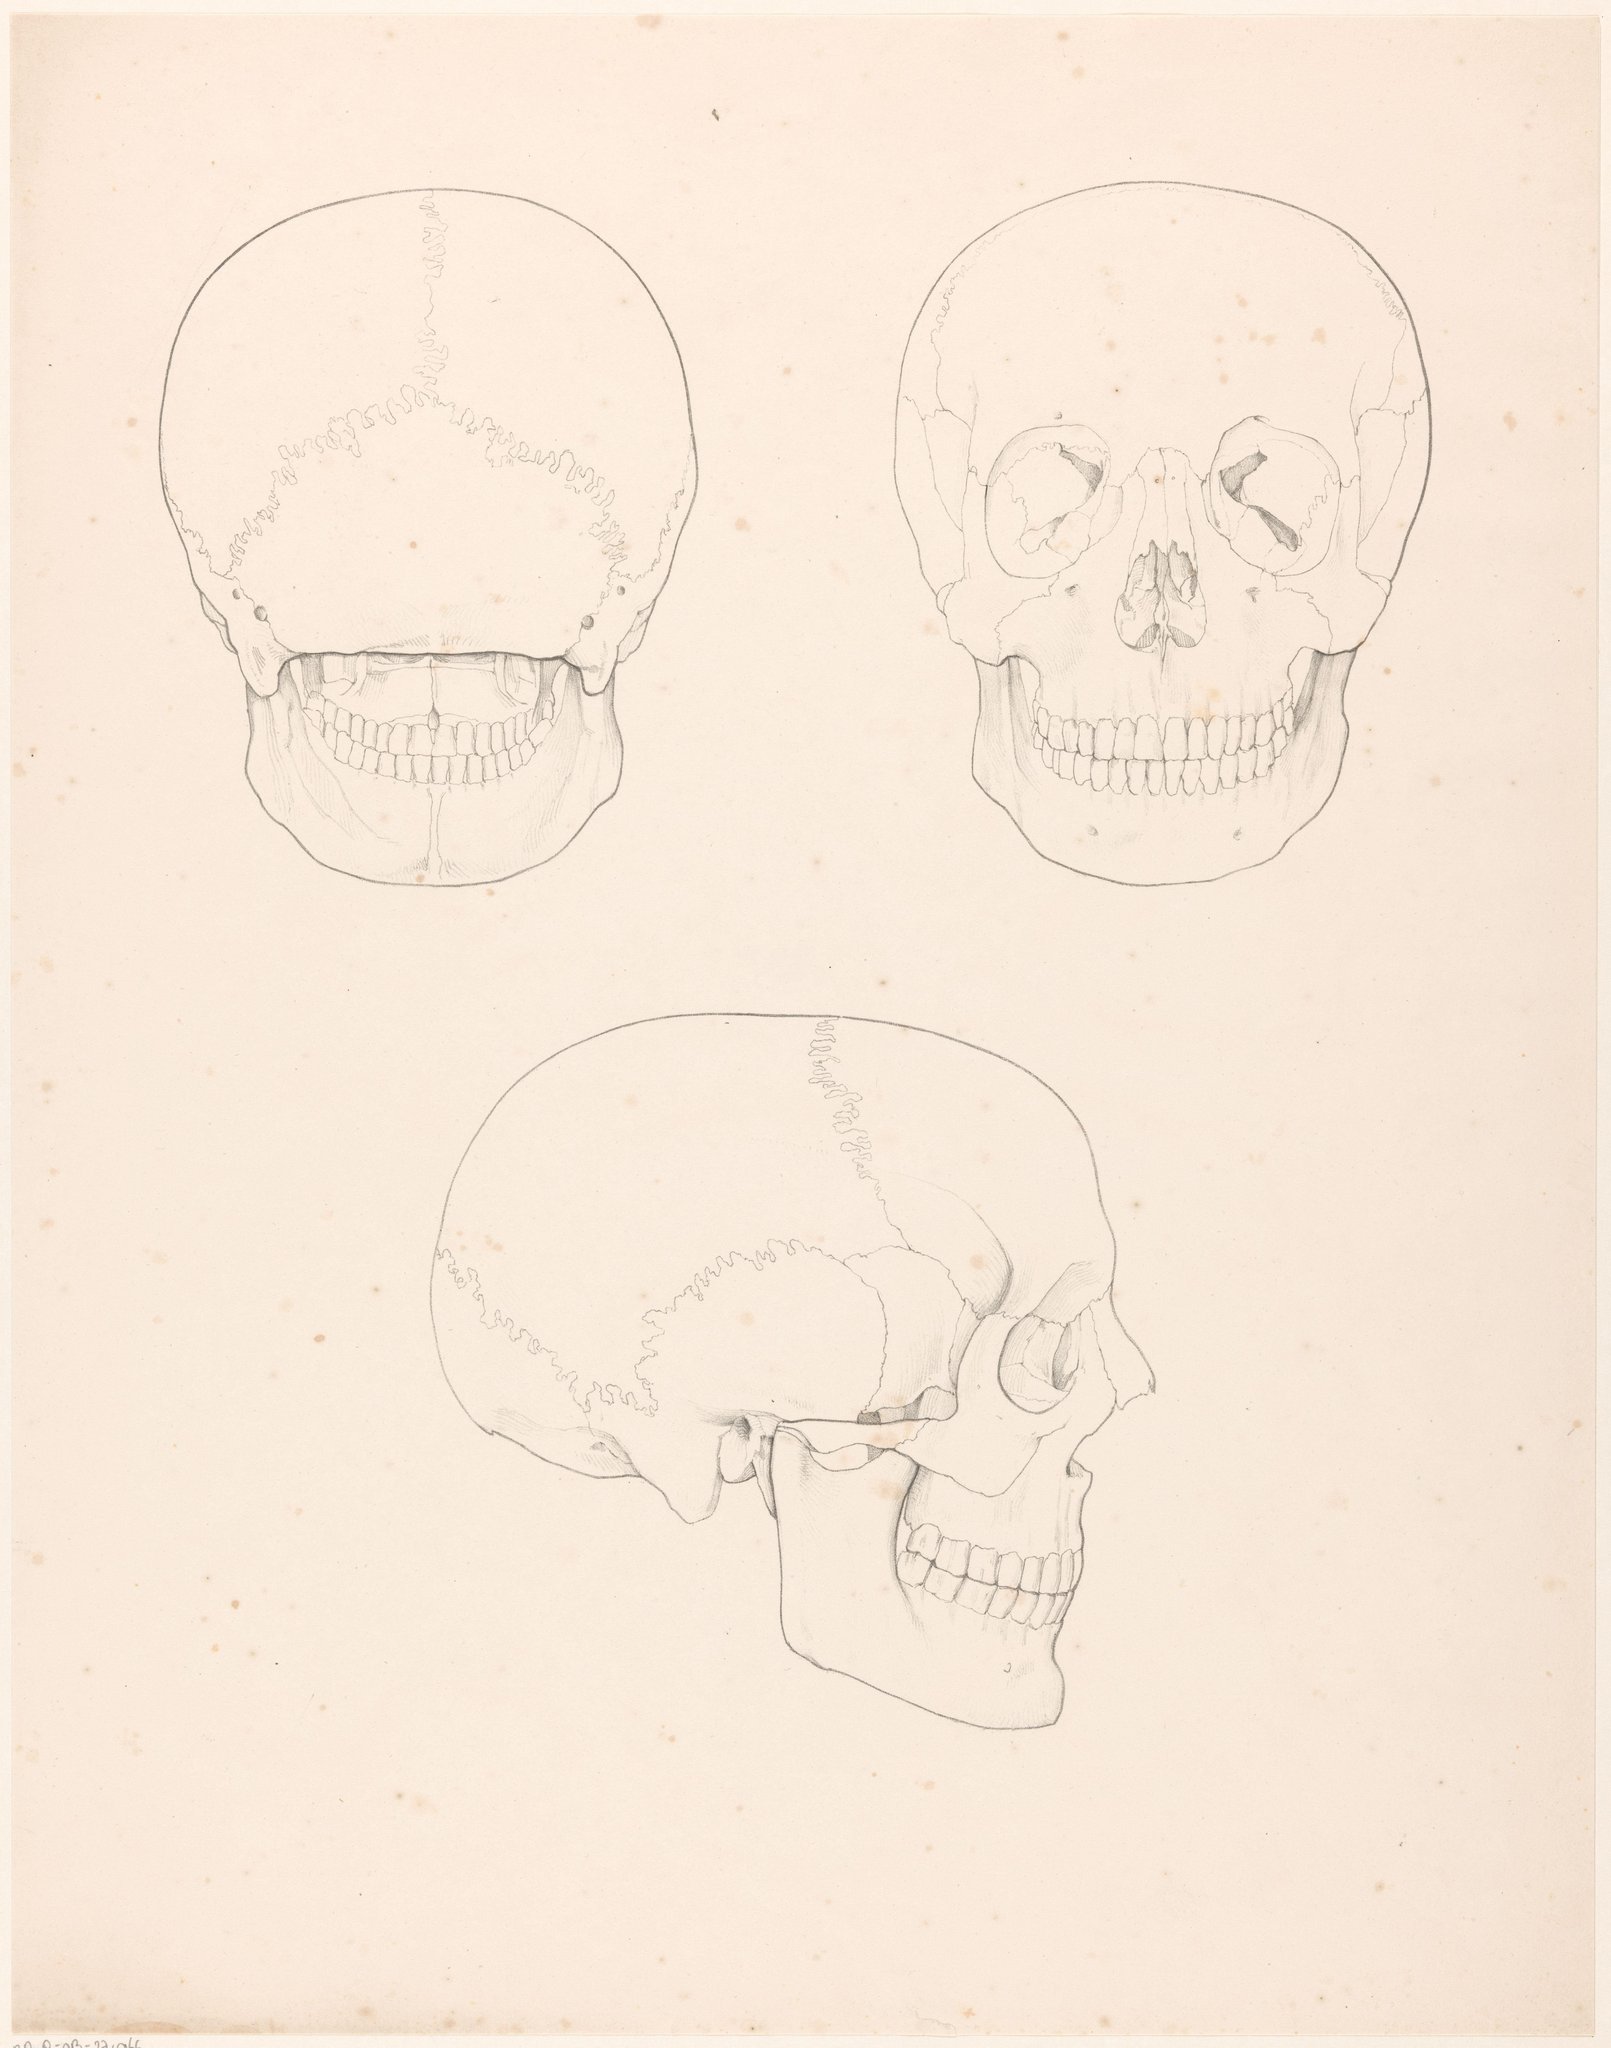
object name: print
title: Menselijke schedel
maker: jean augustin daiwaille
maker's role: draughtsman, print maker, printer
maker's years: 1786-1850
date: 1820-1833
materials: paper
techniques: lithograph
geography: amsterdam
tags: (human) skull (+ front view), (human) skull (+ back view), (human) skull (+ sideview, profile), anatomical model of the muscles, muscle-man, 'écorché'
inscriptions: collector's mark: Lugt 2228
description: De schedel is driemaal afgebeeld, telkens van een ander aanzicht.